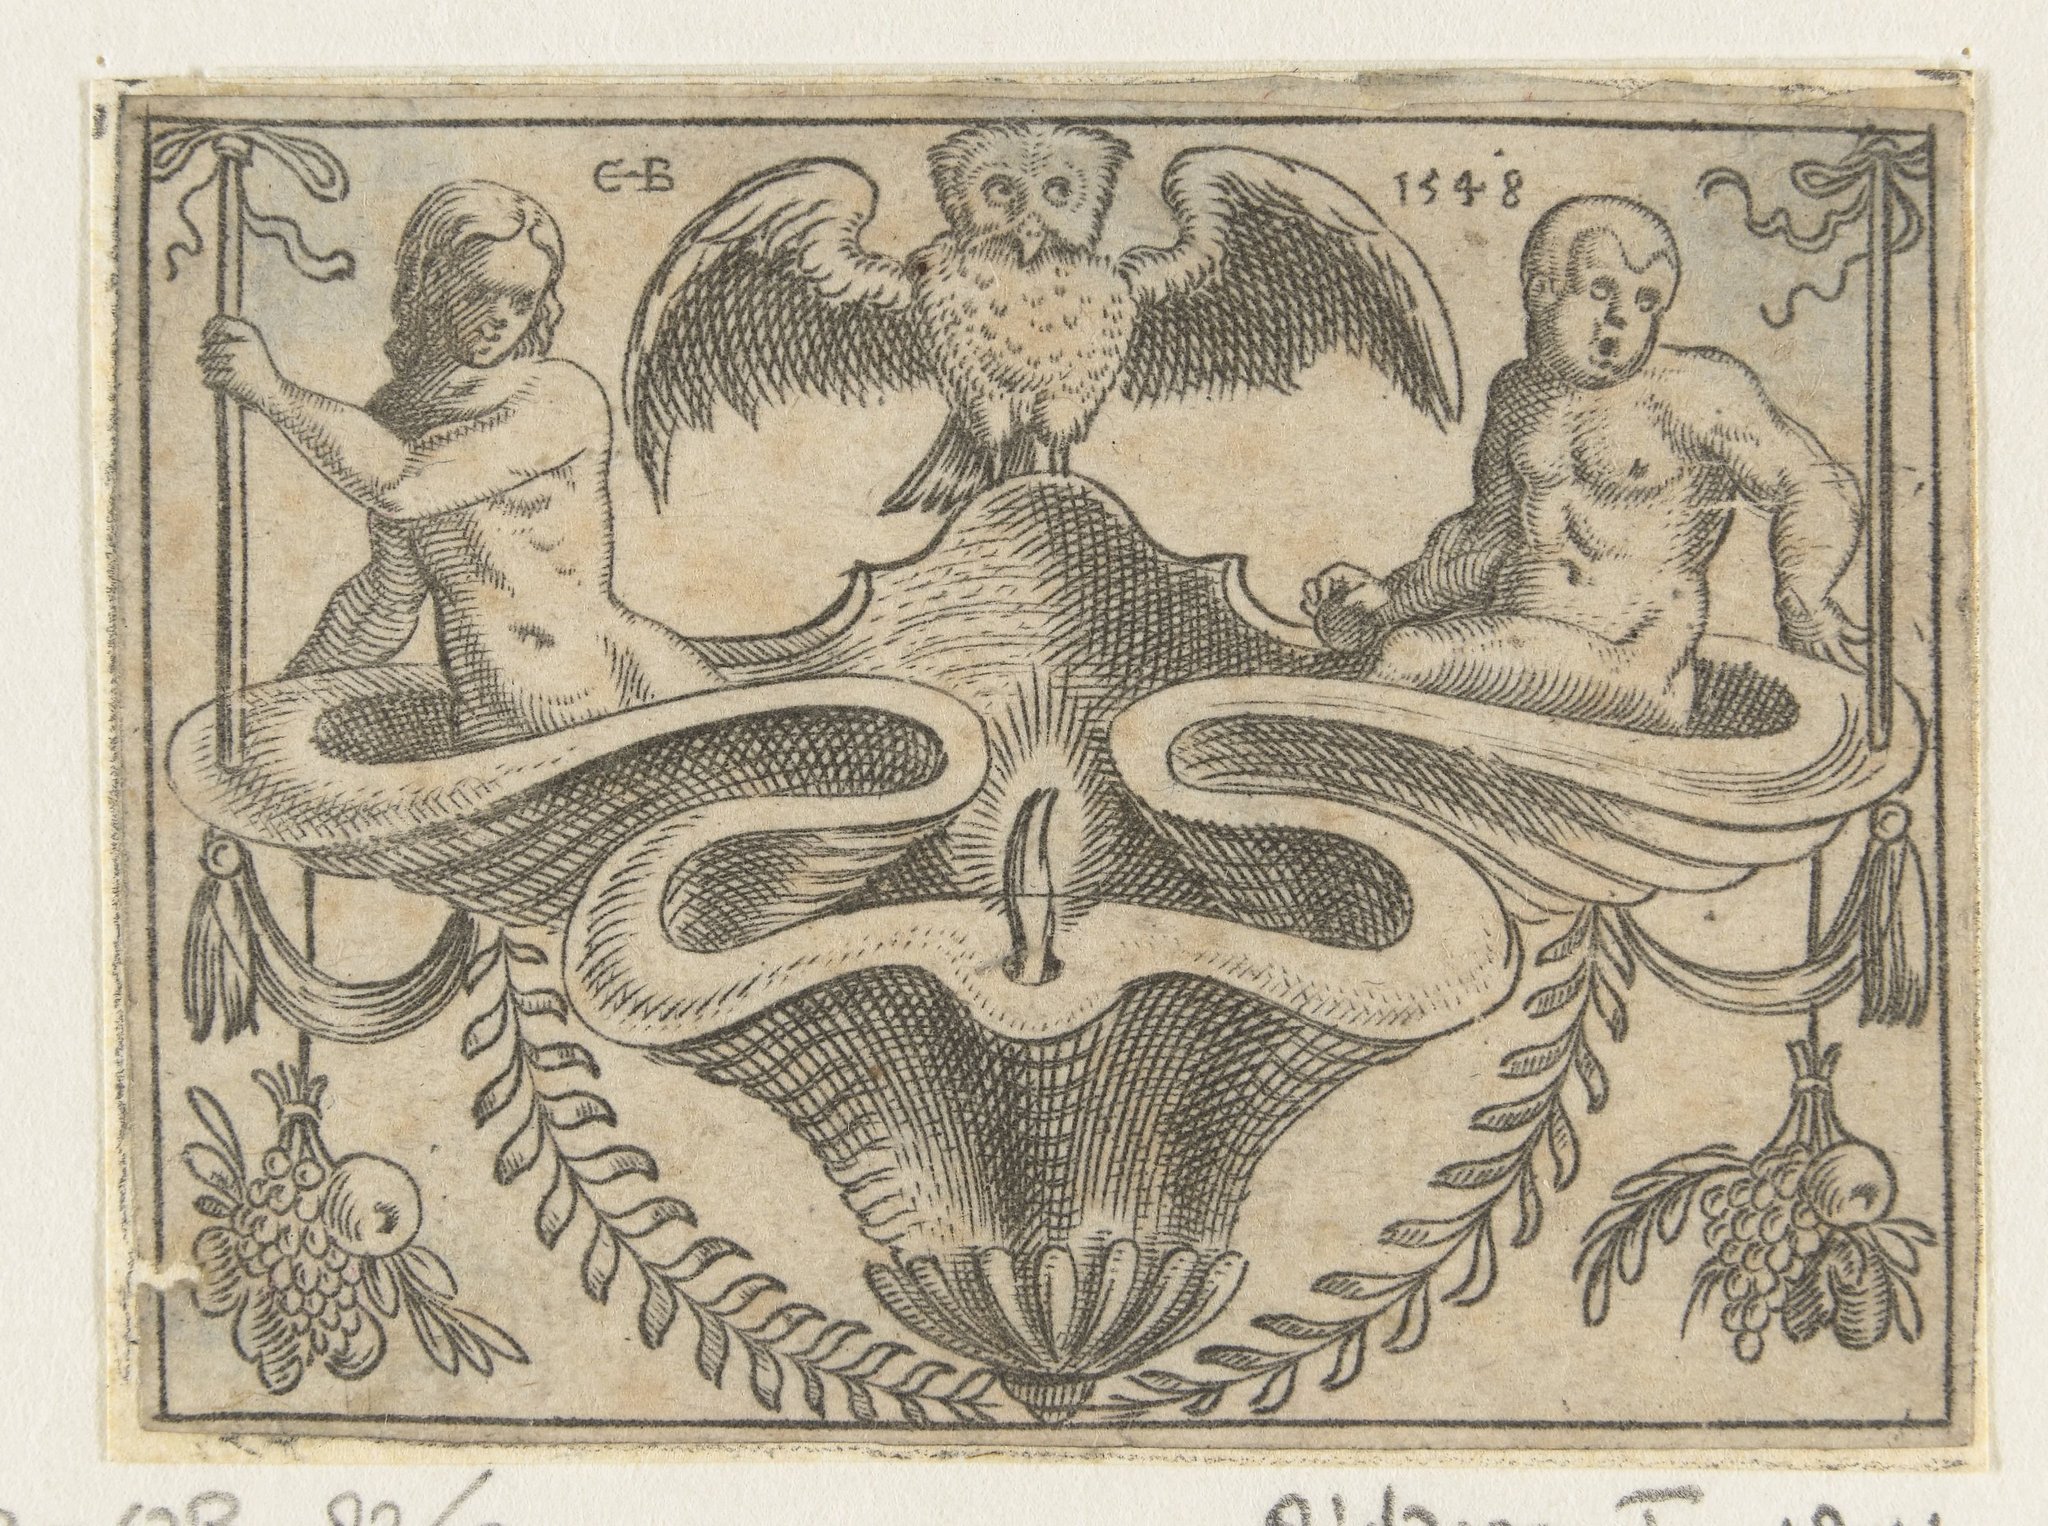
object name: ornament print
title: Kleine vlakdecoraties met grotesken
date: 1548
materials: paper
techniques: engraving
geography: netherlands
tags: fantasy ornament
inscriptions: date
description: In het bekken zitten een man en een vrouw. Midden achter zit een uil, midden voor brandt een vlammetje. Een van 4 bladen uit een serie van 8.